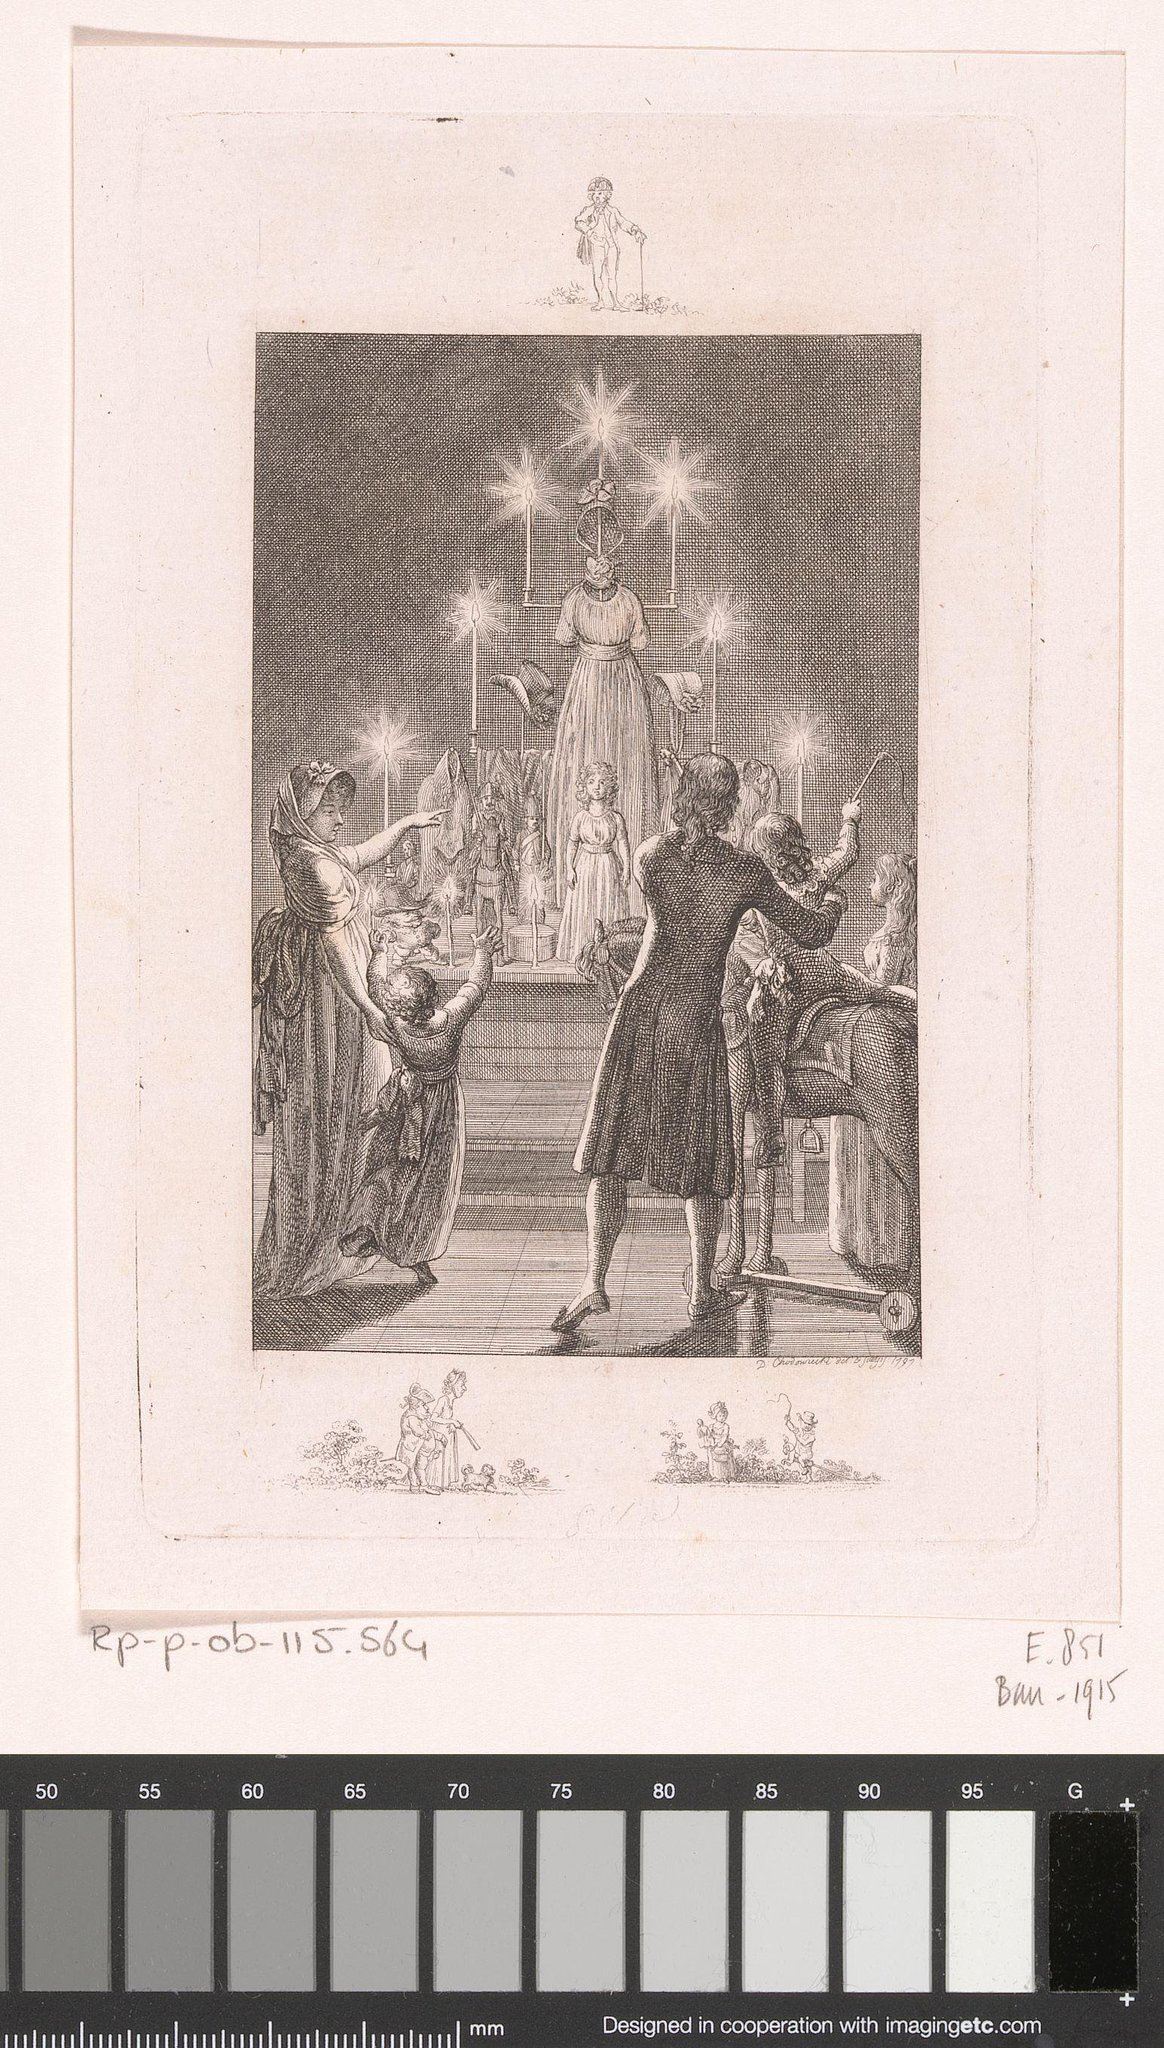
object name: print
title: Huiselijk feest op kerstavond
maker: daniel nikolaus chodowiecki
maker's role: draughtsman, print maker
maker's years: 1726-1801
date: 1797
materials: paper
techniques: etching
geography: berlin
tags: christmas (non-liturgical celebration), candle, bringing gifts; exchanging gifts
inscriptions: collector's mark: Lugt 2228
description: Latere staat gebruikt voor: Lang, Karl. Almanach und Taschenbuch für Häusliche und Gesellschaftl. Freuden (...). Heilbronn: Industrie Comtoir, 1799.